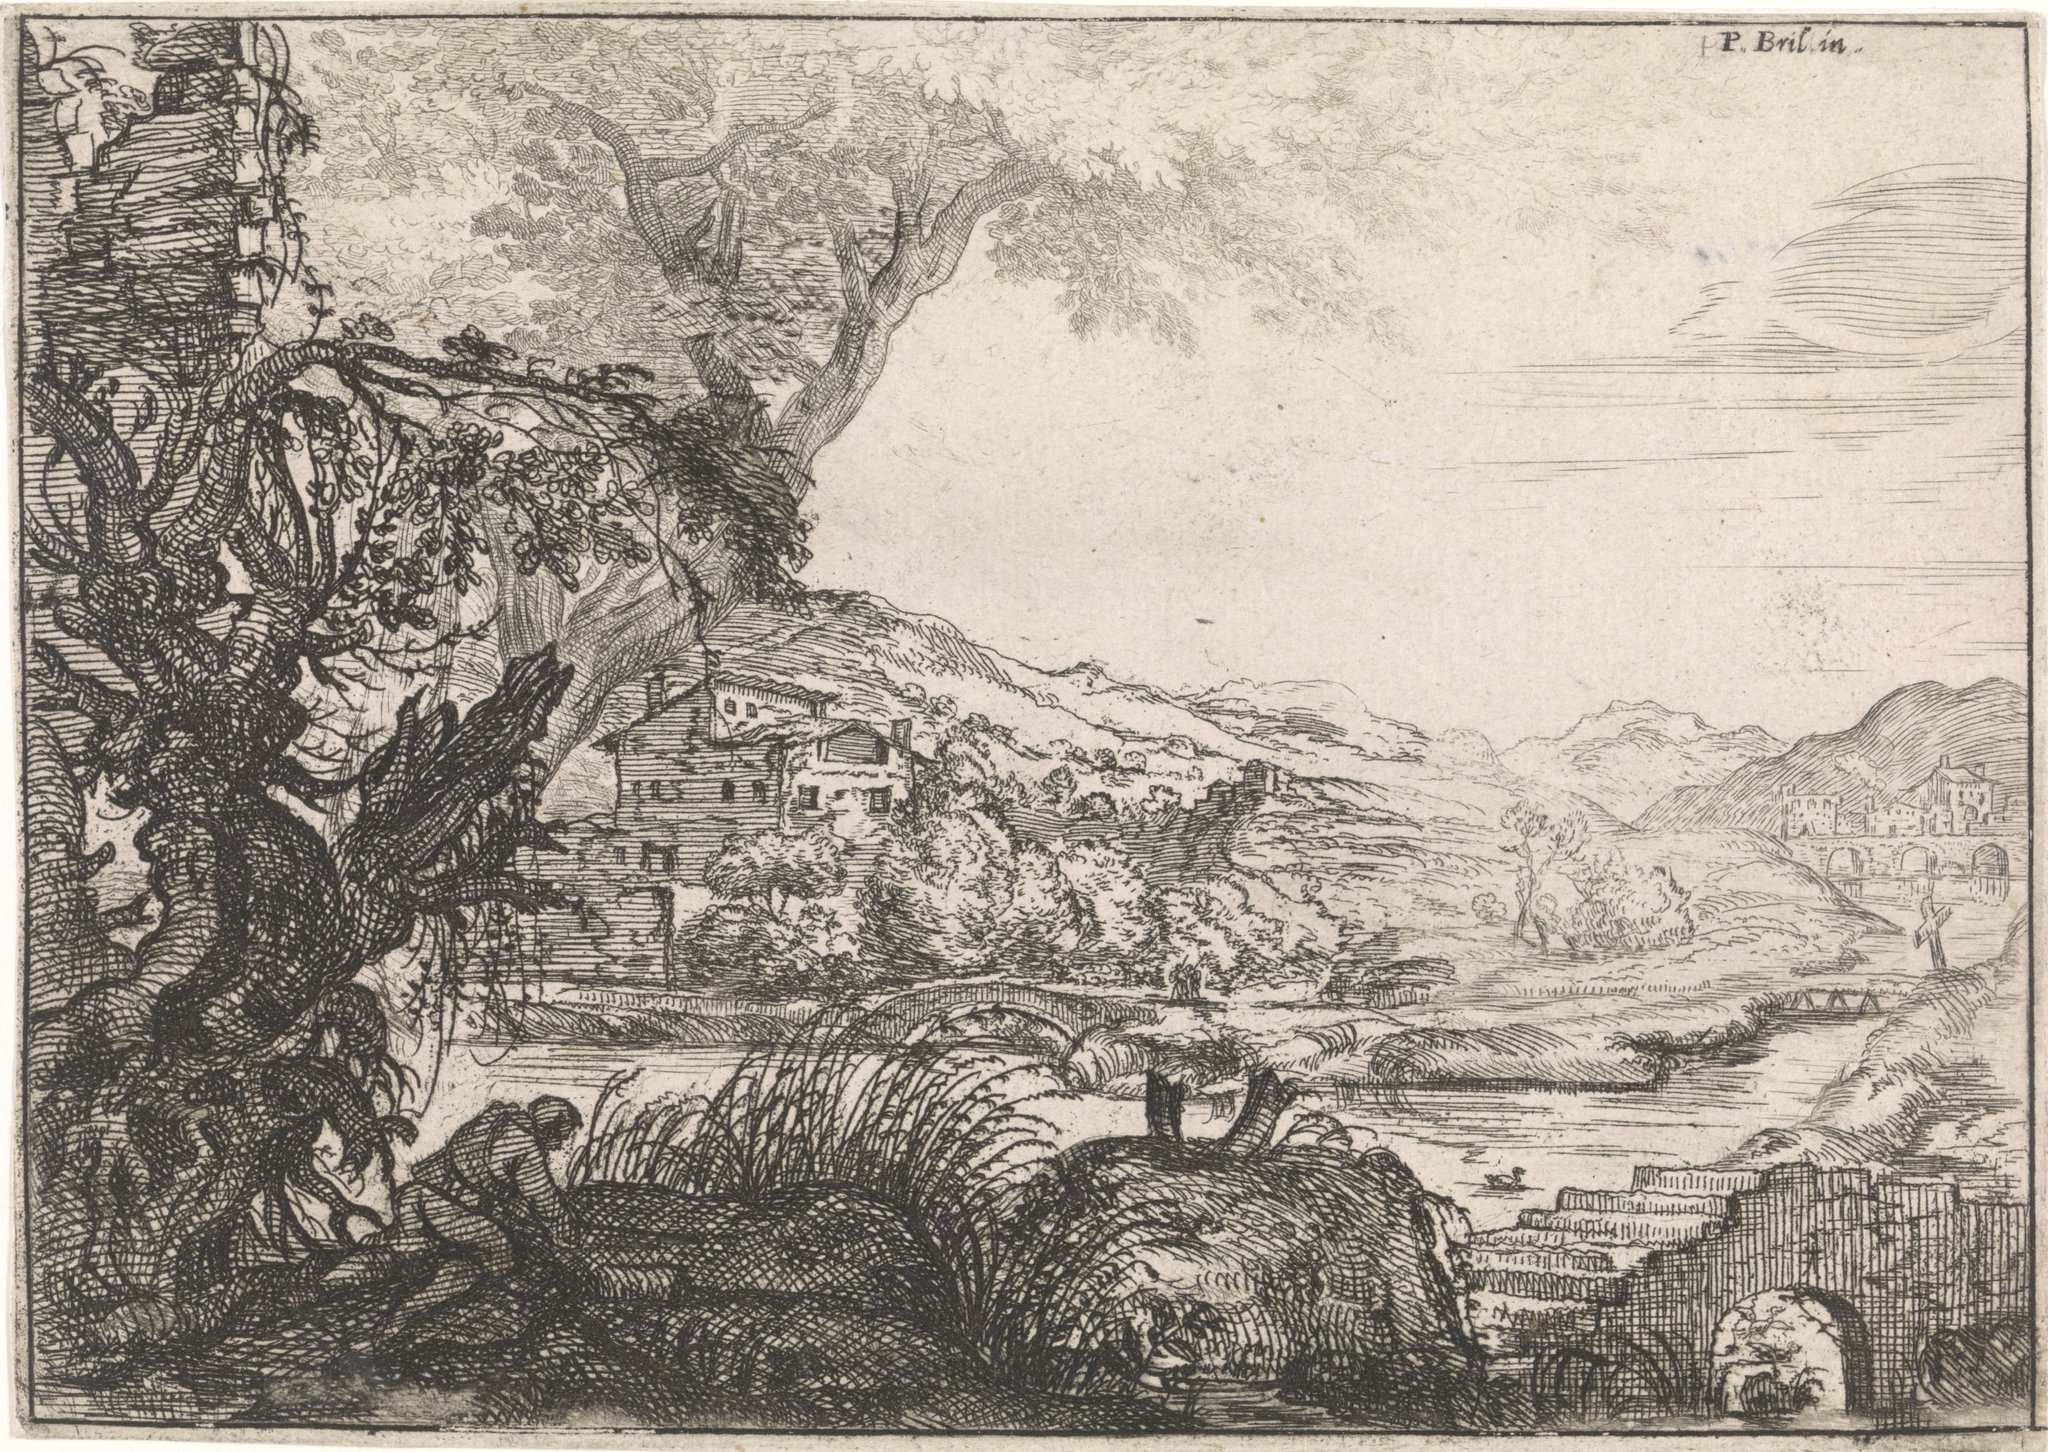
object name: print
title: Landschap met een man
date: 1622-1703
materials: paper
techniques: etching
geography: antwerp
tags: landscapes - hh - ideal landscapes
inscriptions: collector's mark: Lugt 2228, inscription: ‘gedeelte’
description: Landschap met links op de voorgrond een man die bij een boom knielt. Op de achtergrond een rivier en rechts een stenen brug.